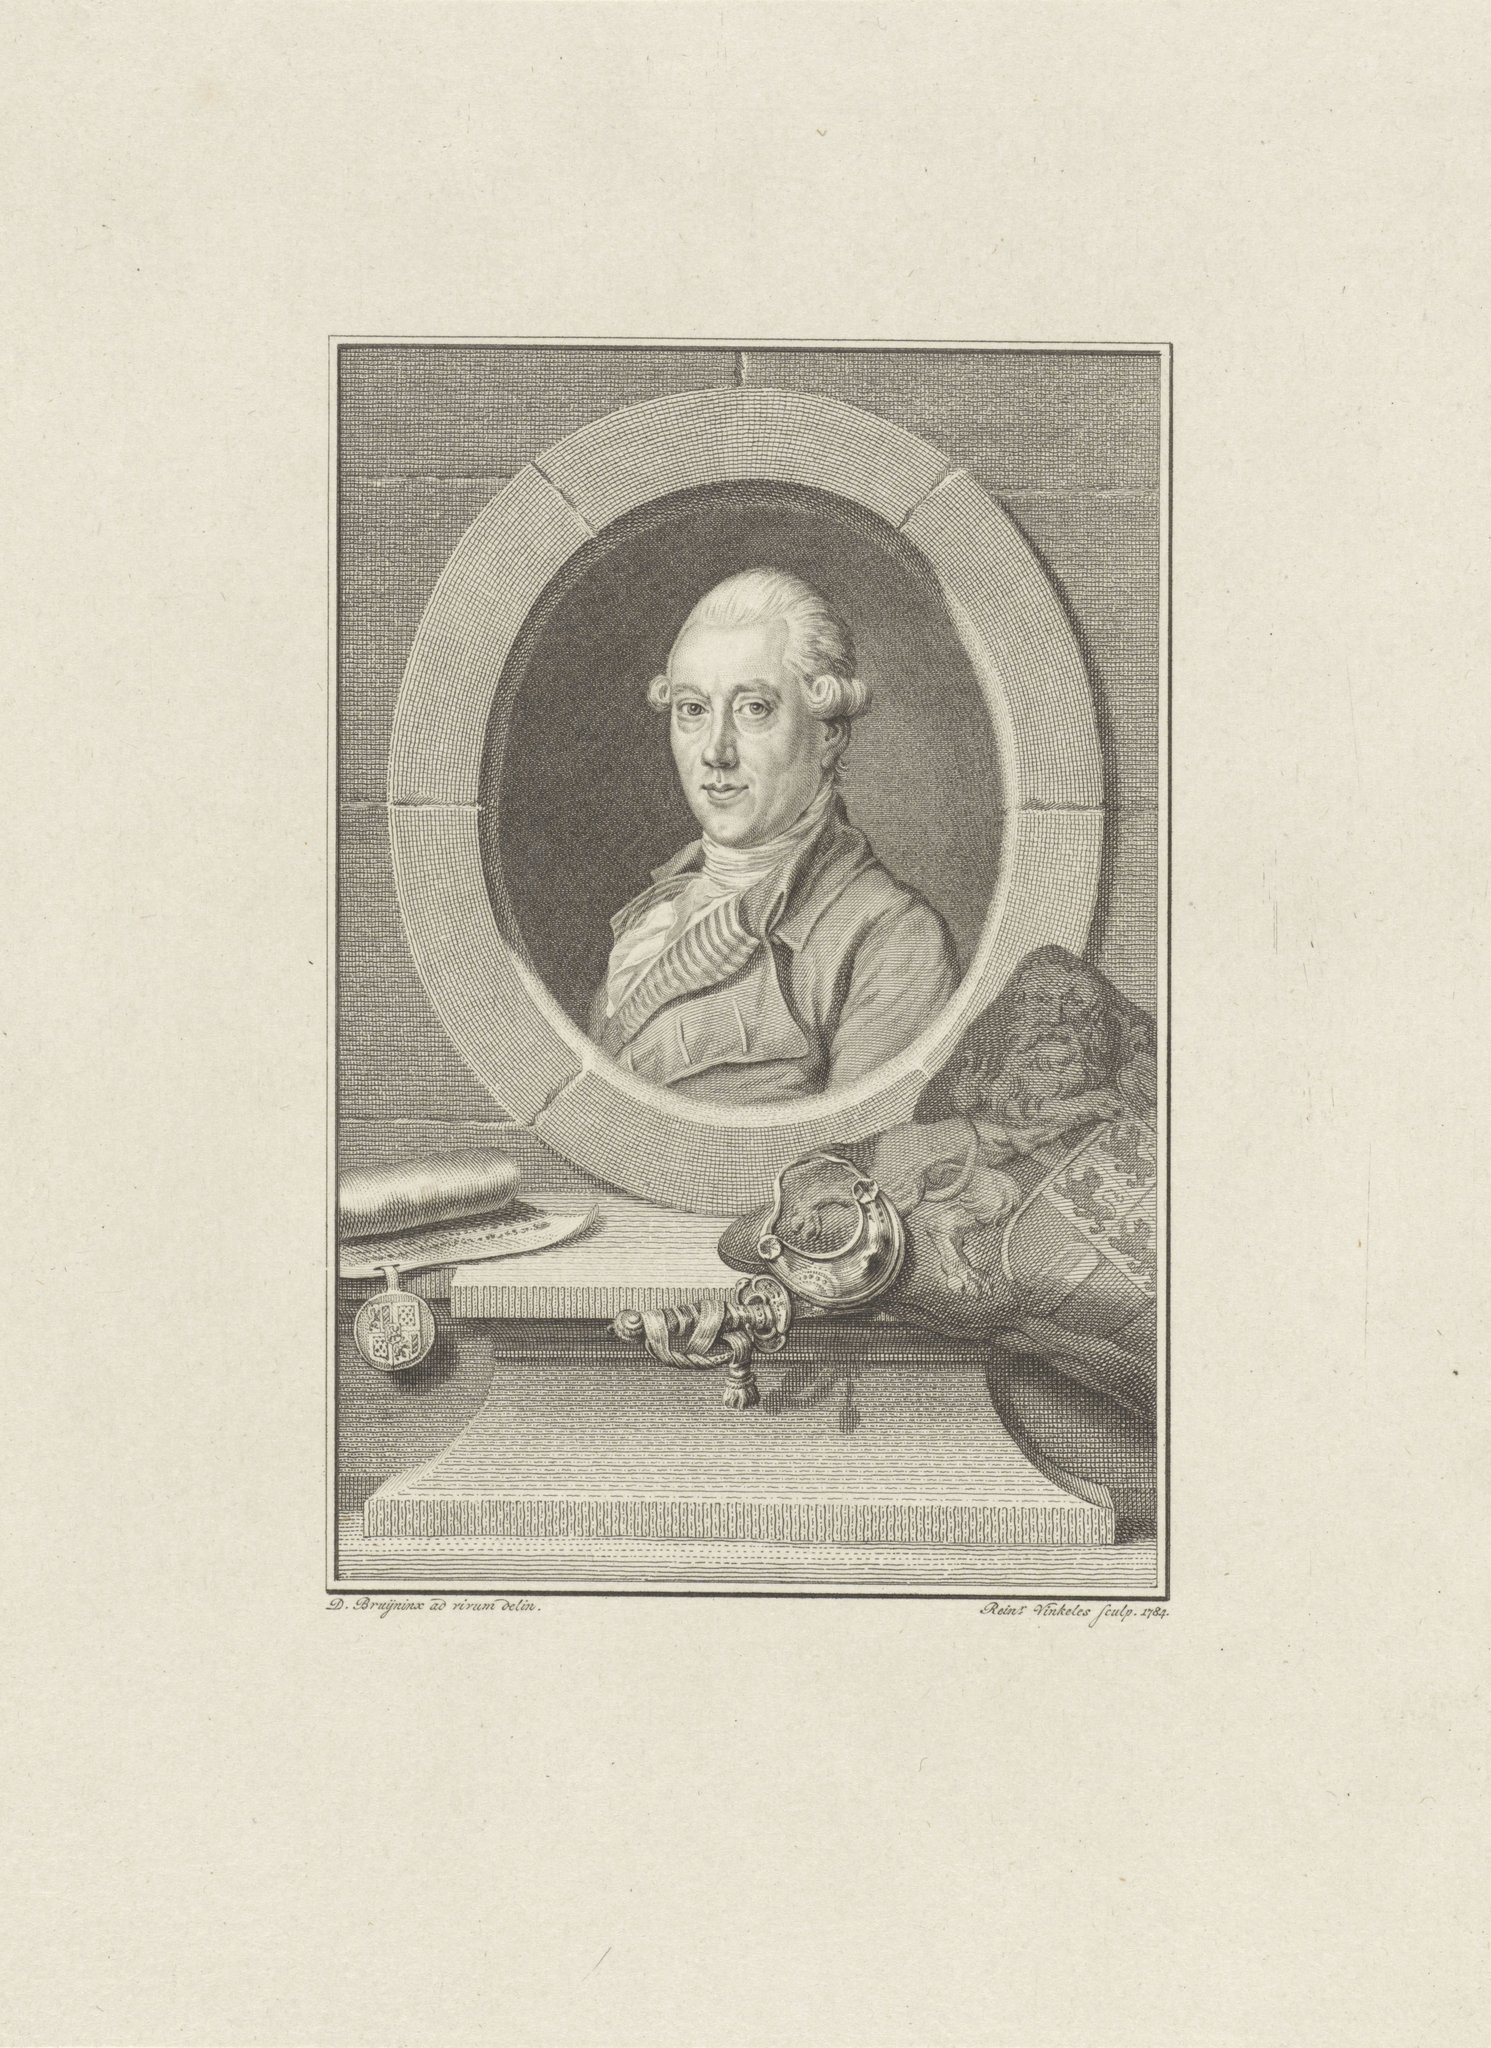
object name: print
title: Portret van Jan Jacob Elsevier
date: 1784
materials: paper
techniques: engraving, etching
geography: amsterdam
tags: delfshaven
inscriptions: collector's mark: Lugt 240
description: Portret van Jan Jacob Elsevier, vroedschapslid en kolonel van de schutterij van de stad Rotterdam.